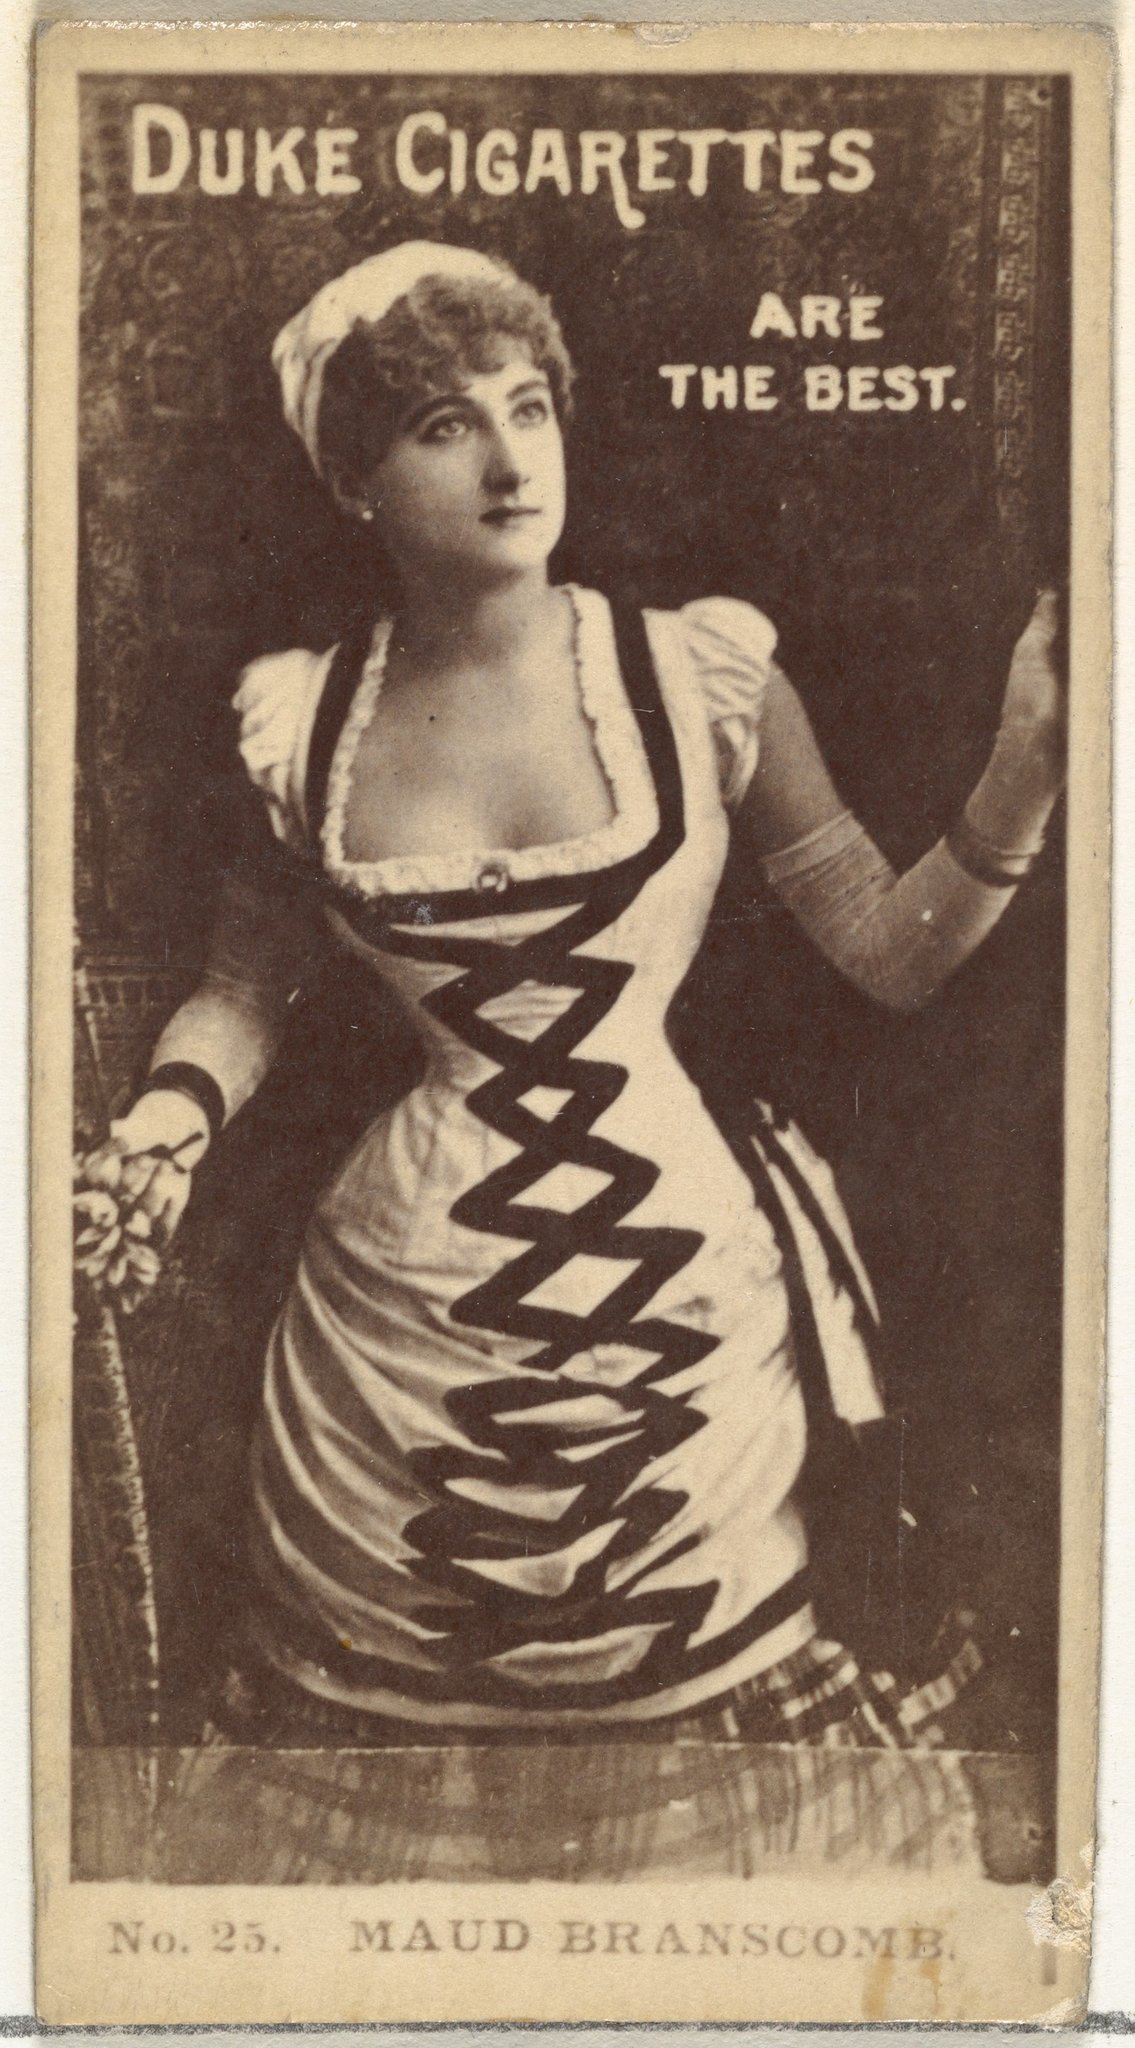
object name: photograph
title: Card Number 25, Maud Branscomb, from the Actors and Actresses series (N145-6) issued by Duke Sons & Co. to promote Duke Cigarettes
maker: w. duke, sons & co.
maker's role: publisher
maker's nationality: american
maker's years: 1870-1920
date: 1880-1889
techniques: albumen silver print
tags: portraits,women,actresses